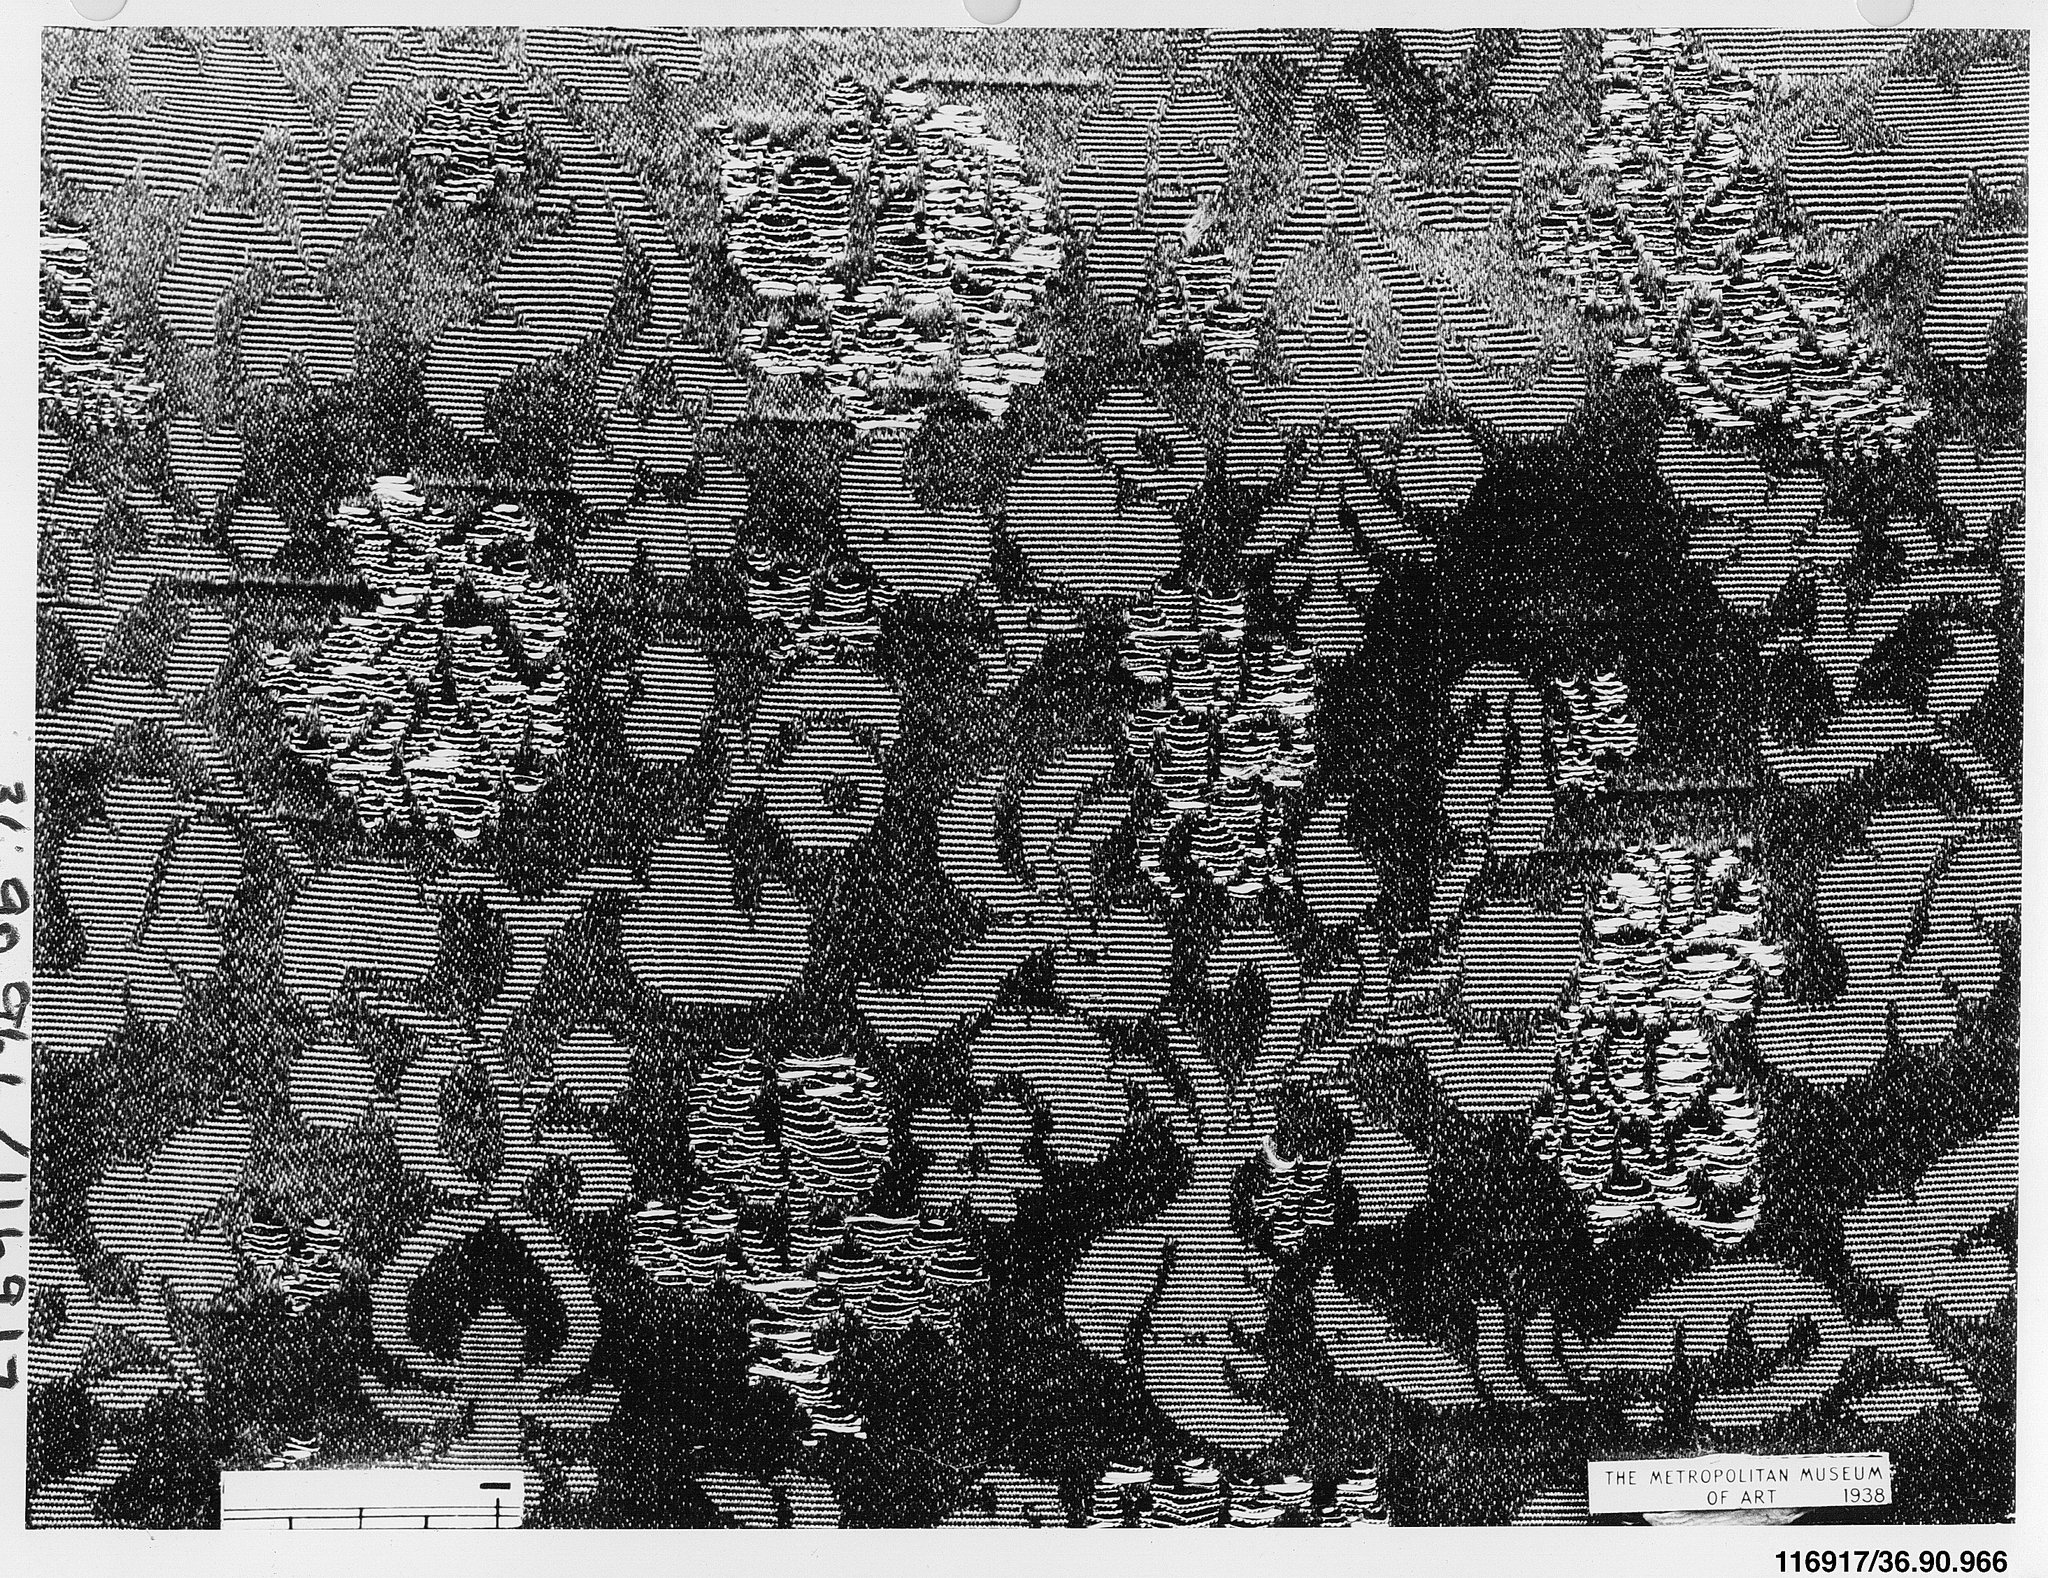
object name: piece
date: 1601-1700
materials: metal thread, silk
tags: flowers